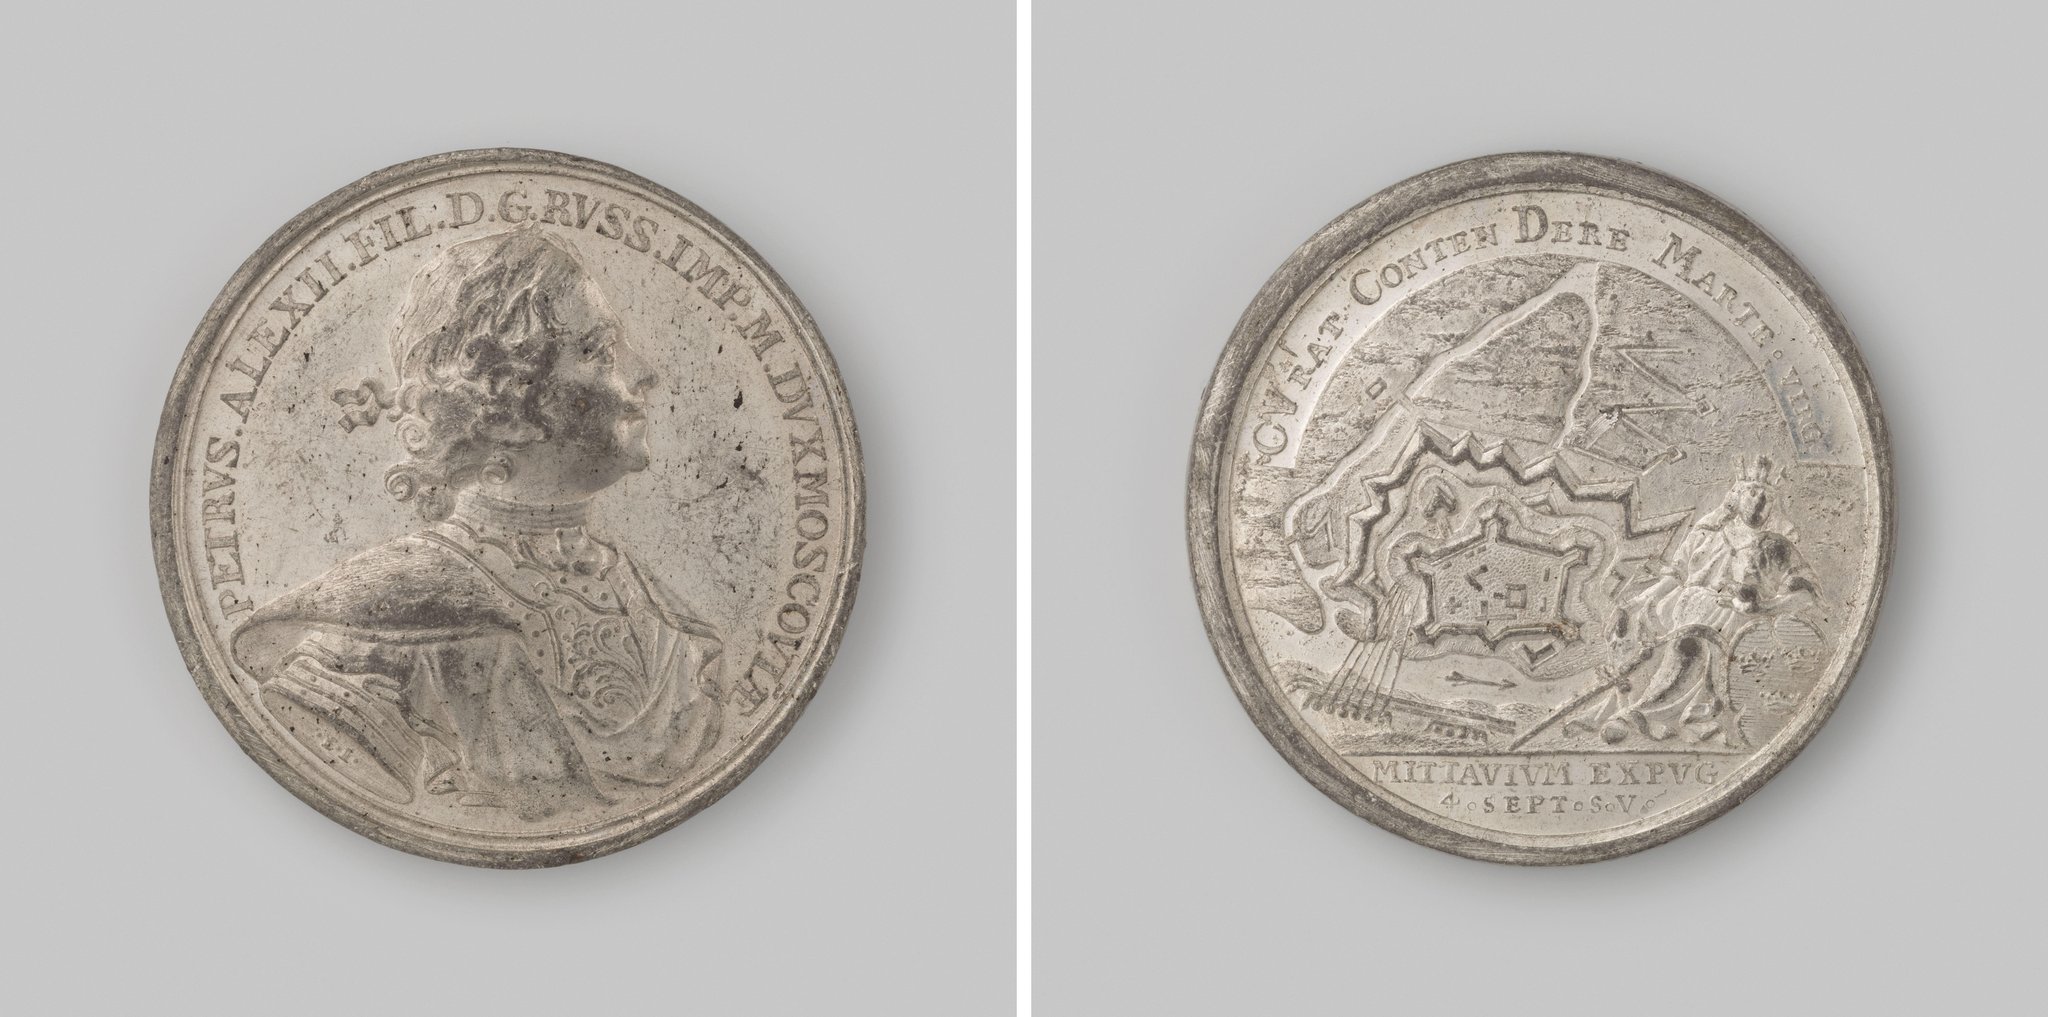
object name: history medal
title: Inname van Mittau door Rusland op Zweden 1705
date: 1705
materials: tin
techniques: striking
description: Tinnen penning, op de voorzijde het borstbeeld van Tsaar Peter de Grote naar rechts met omschrift, op de keerzijde de stadsgod die zittend het zwaard laat vallen met op de achtergrond de plattegrond van de beschieting van Mittau, met omschrift en afsnedetekst.